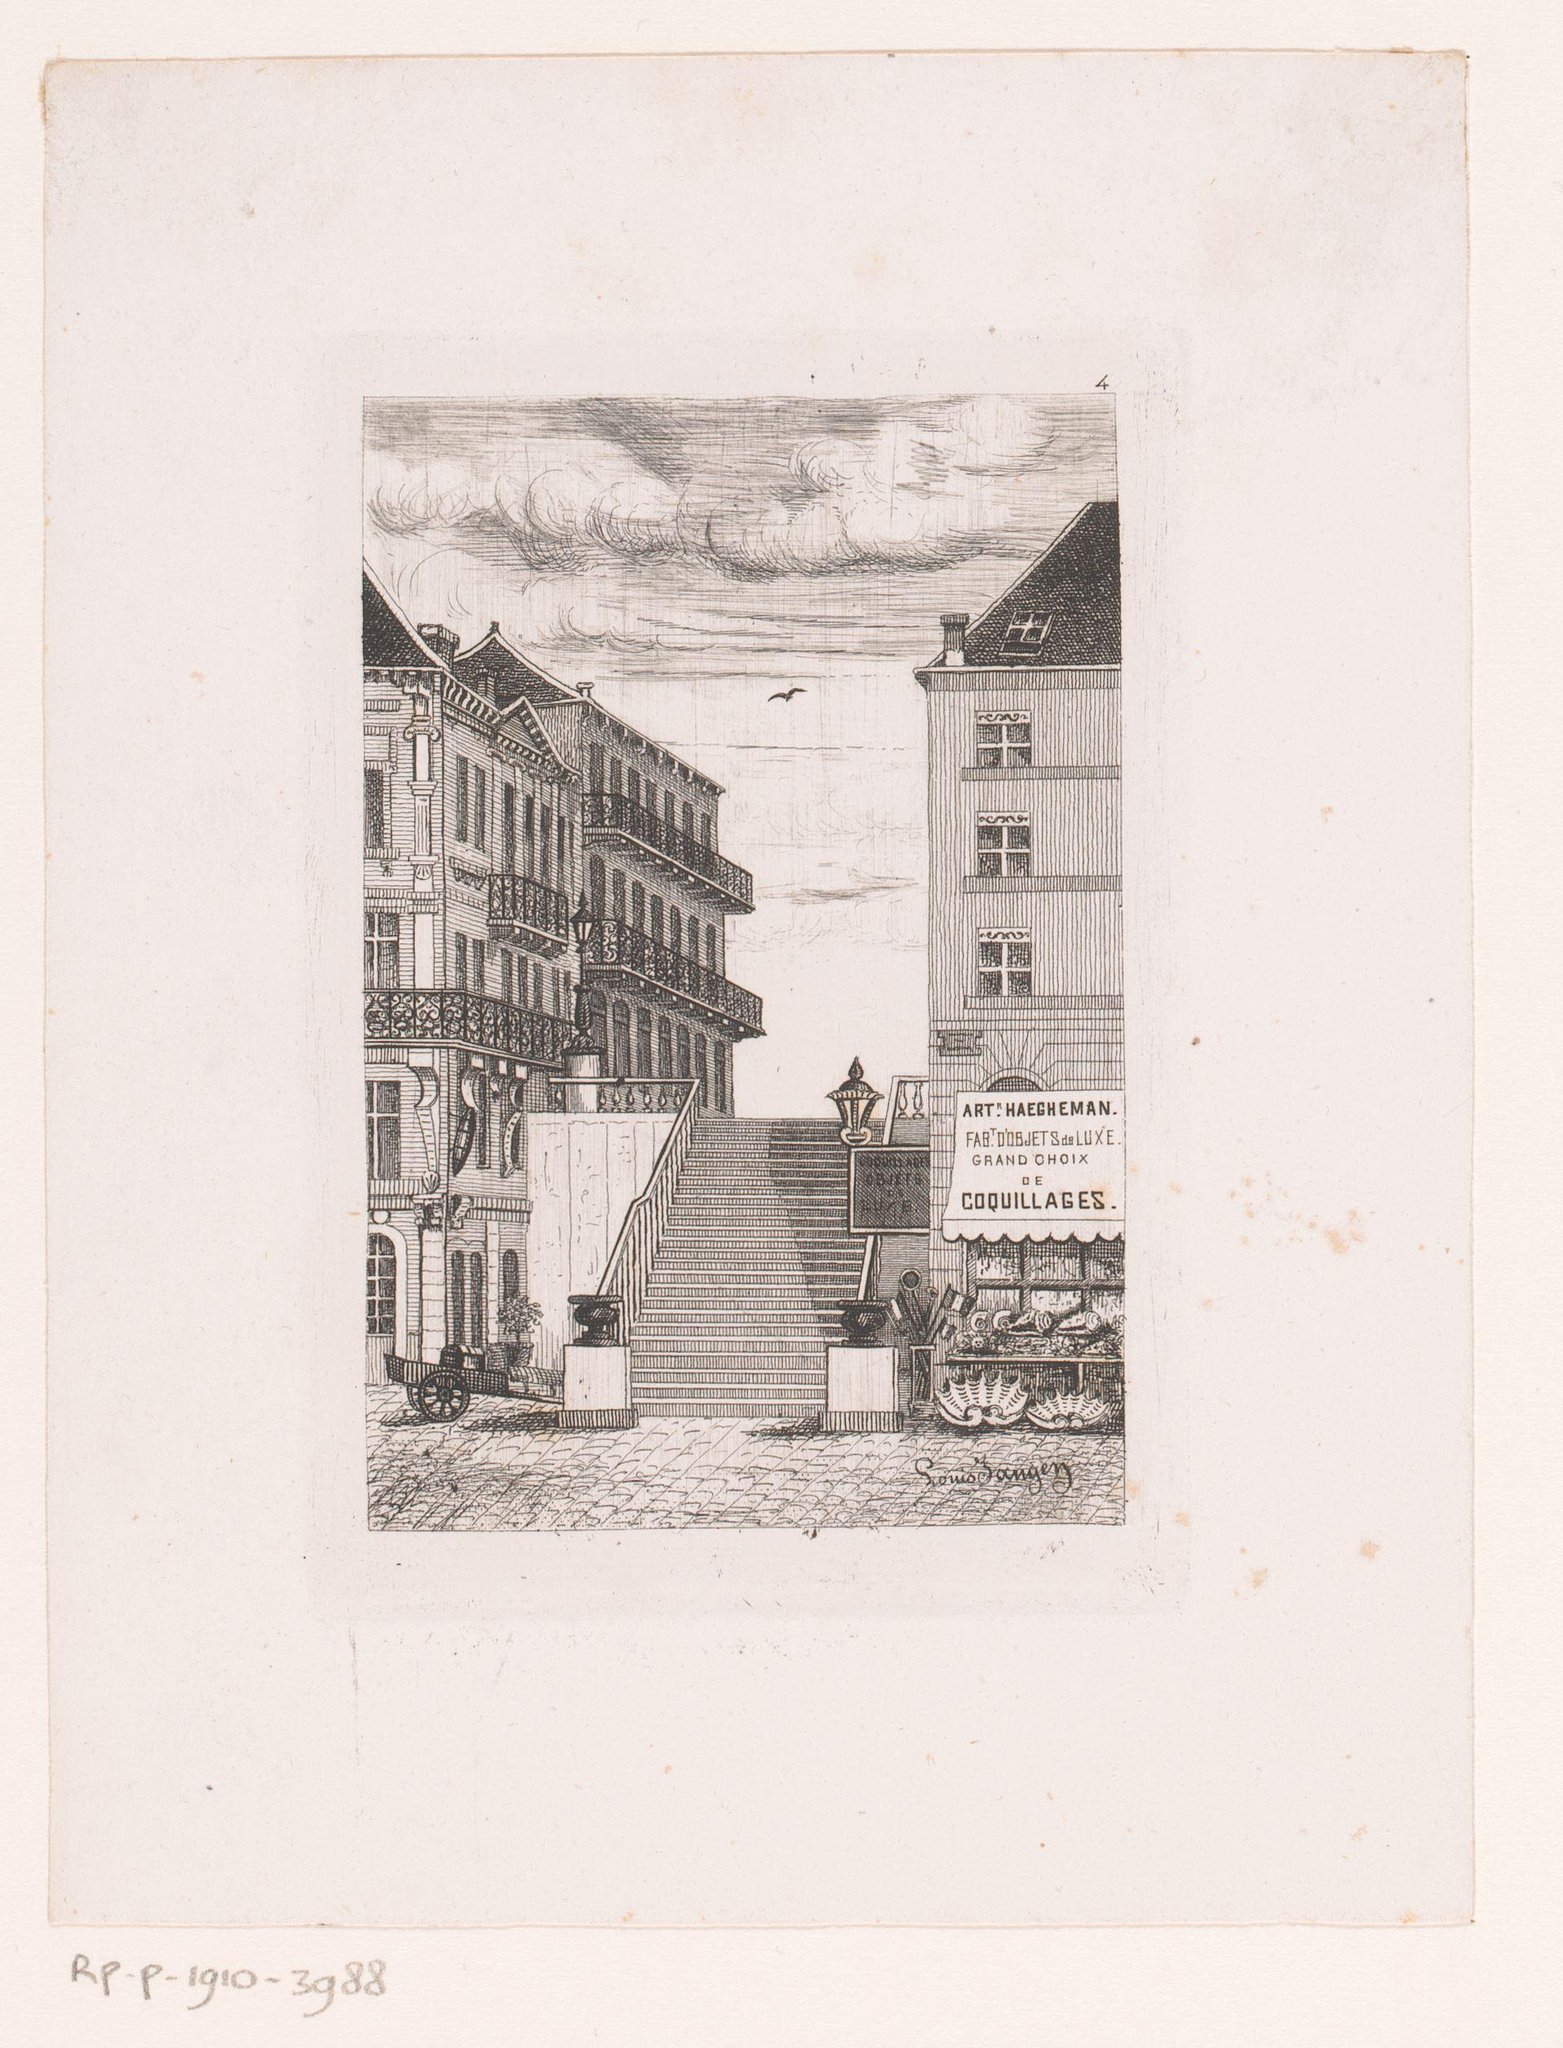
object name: print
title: Gezicht op huizen en grote trap te Blankenberge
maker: louis jaugey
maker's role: print maker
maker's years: 1837-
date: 1850-1899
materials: paper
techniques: etching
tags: shop, store, city-view in general; 'veduta', sloping street; street with steps or stairs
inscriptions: collector's mark: Lugt 2228